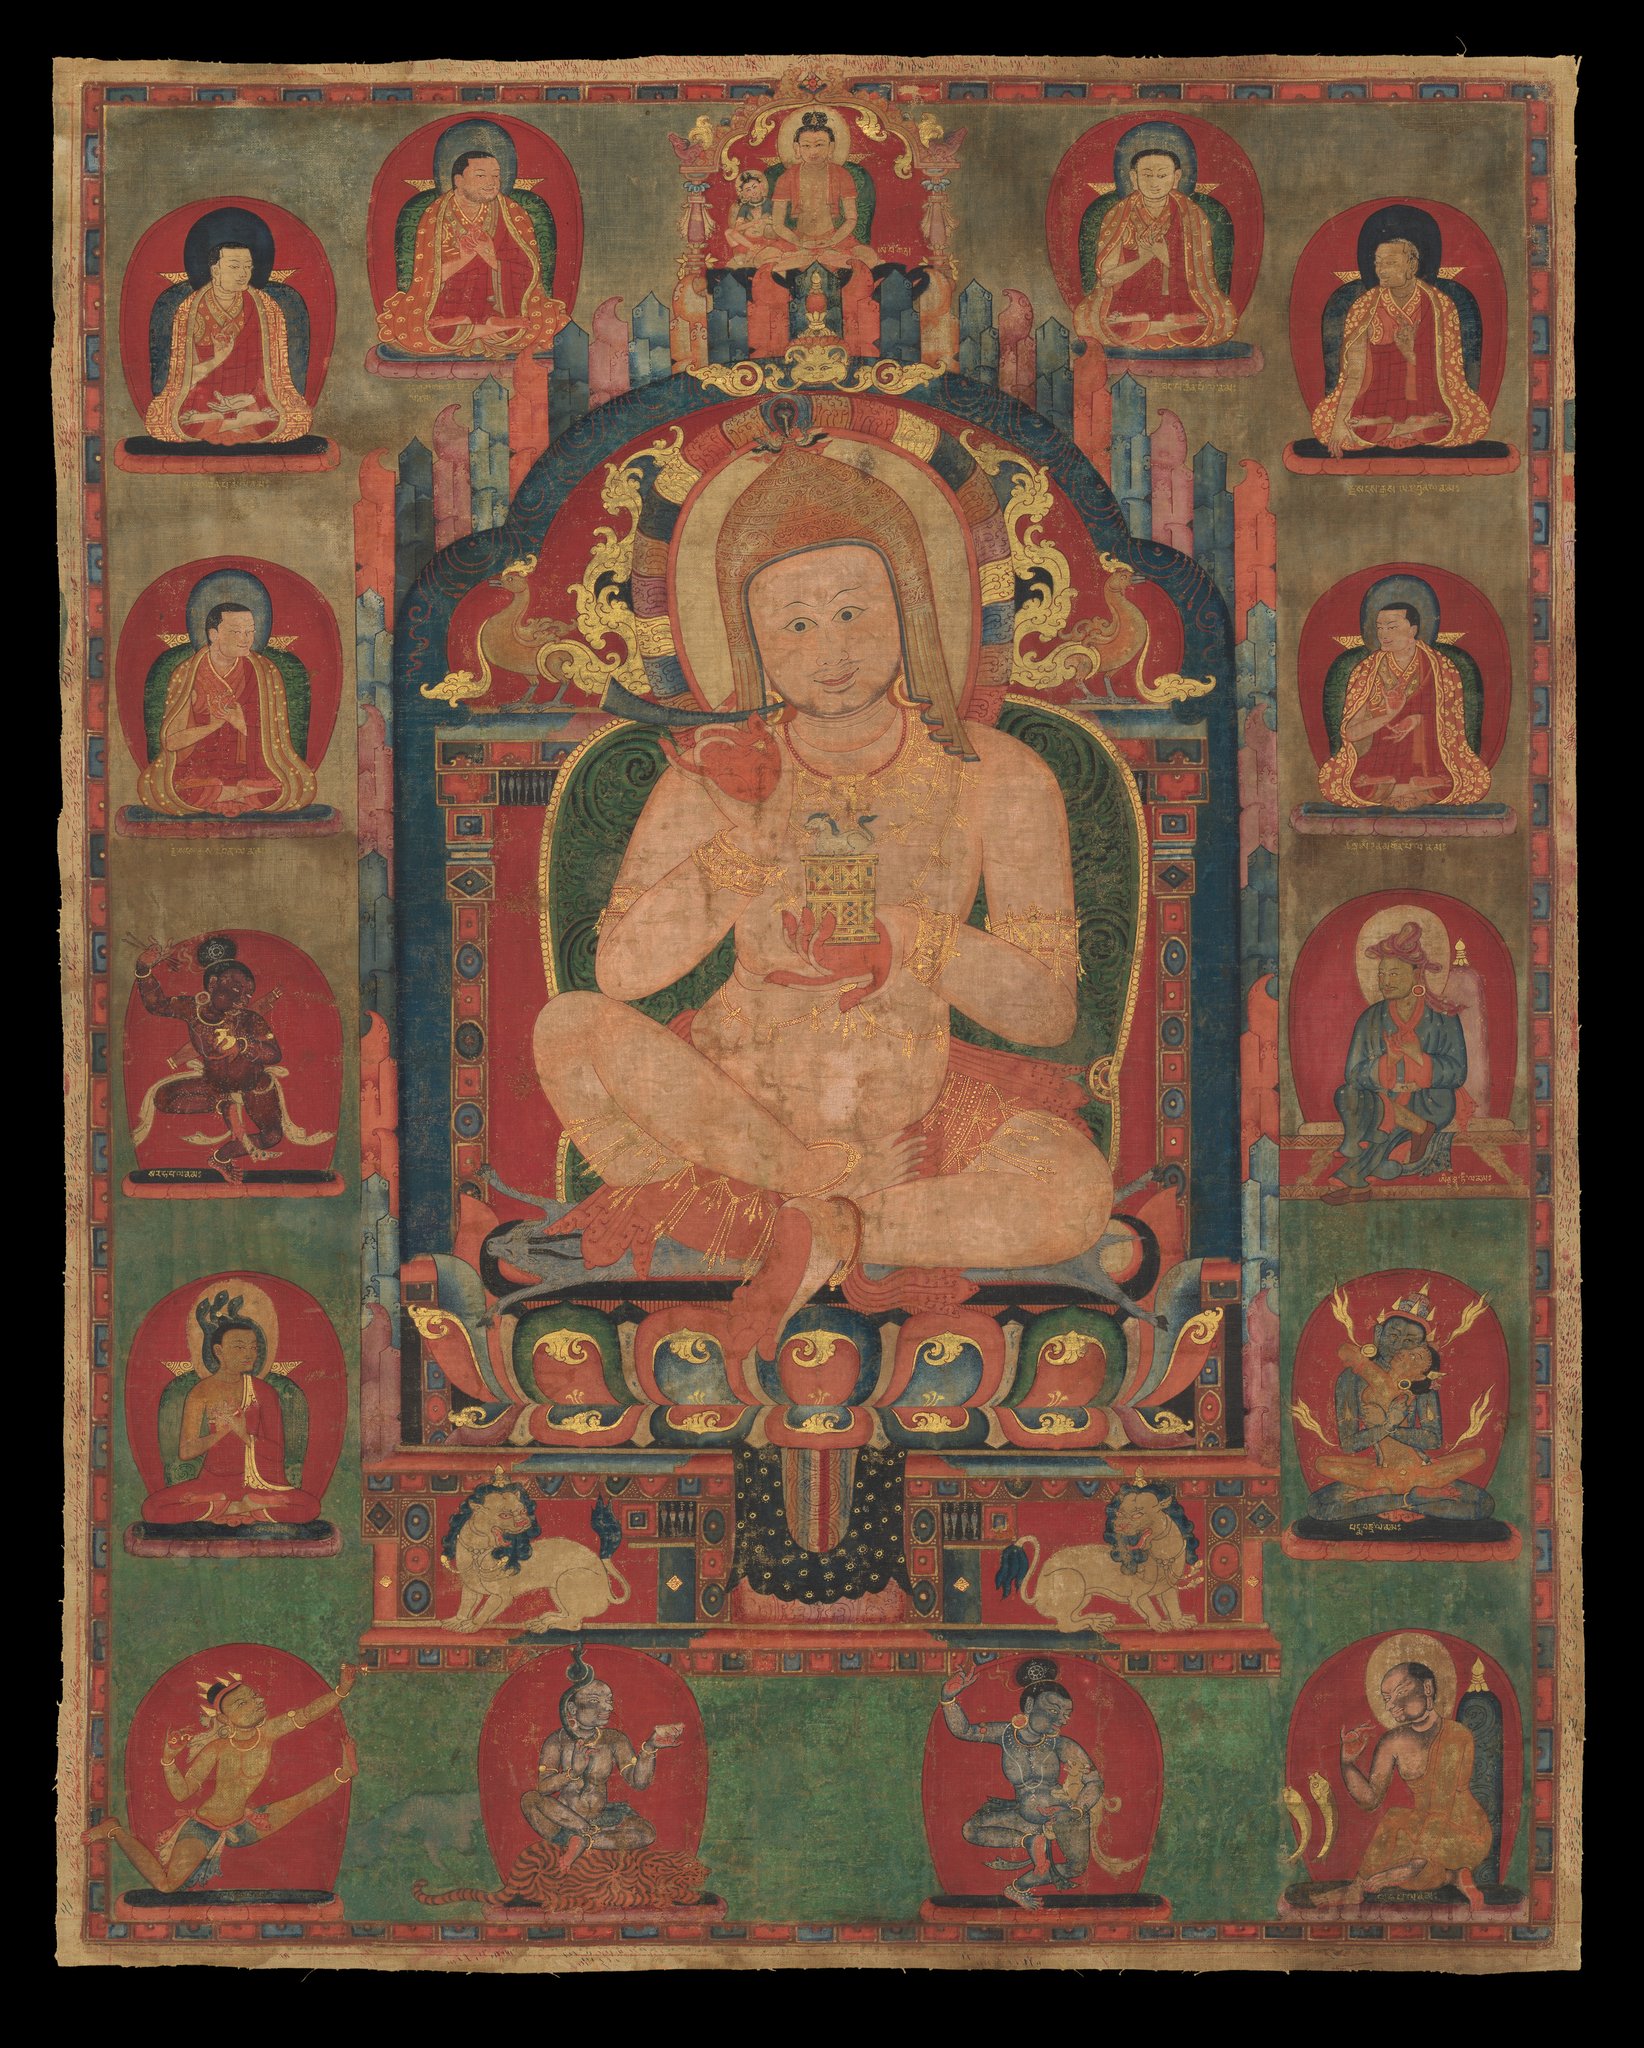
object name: painting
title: Mahasiddha Jnanatapa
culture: tibet, eastern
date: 1350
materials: textile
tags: animals,men,portraits